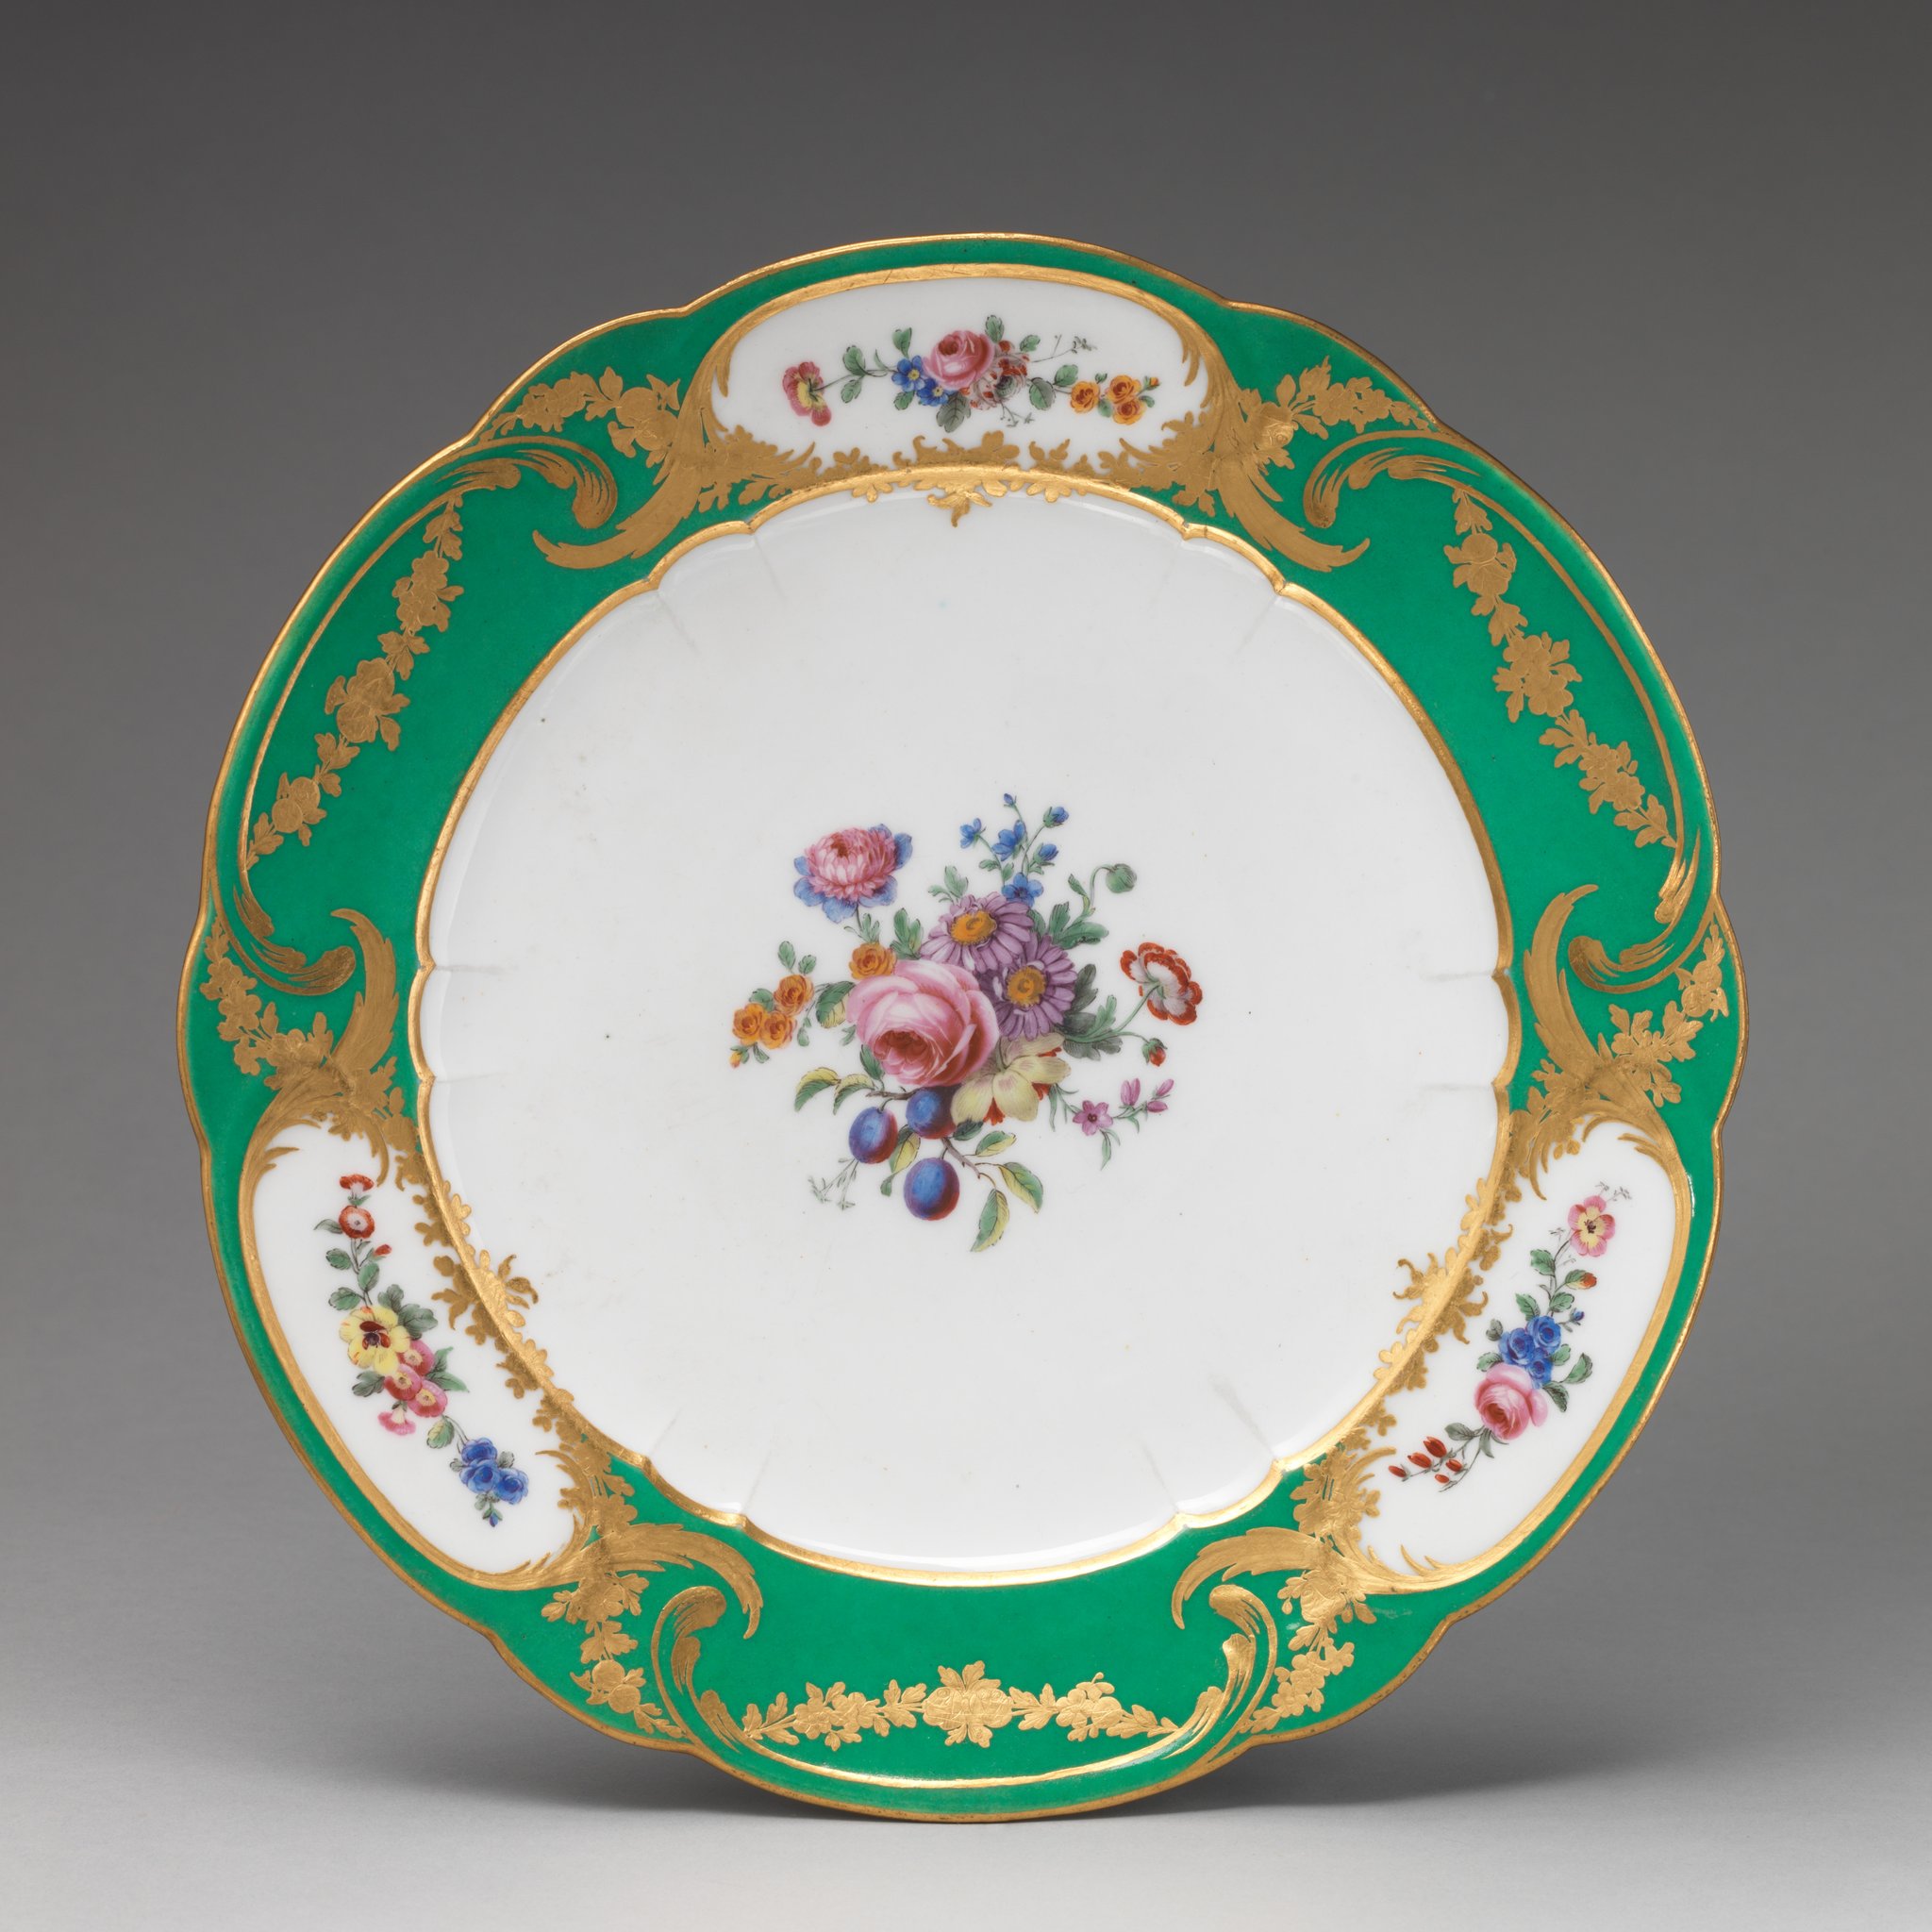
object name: plate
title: Plate (assiette à palmes) (1 of 102) (part of a service)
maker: sèvres manufactory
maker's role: manufactory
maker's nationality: french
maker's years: 1740-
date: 1780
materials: soft paste porcelain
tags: flowers